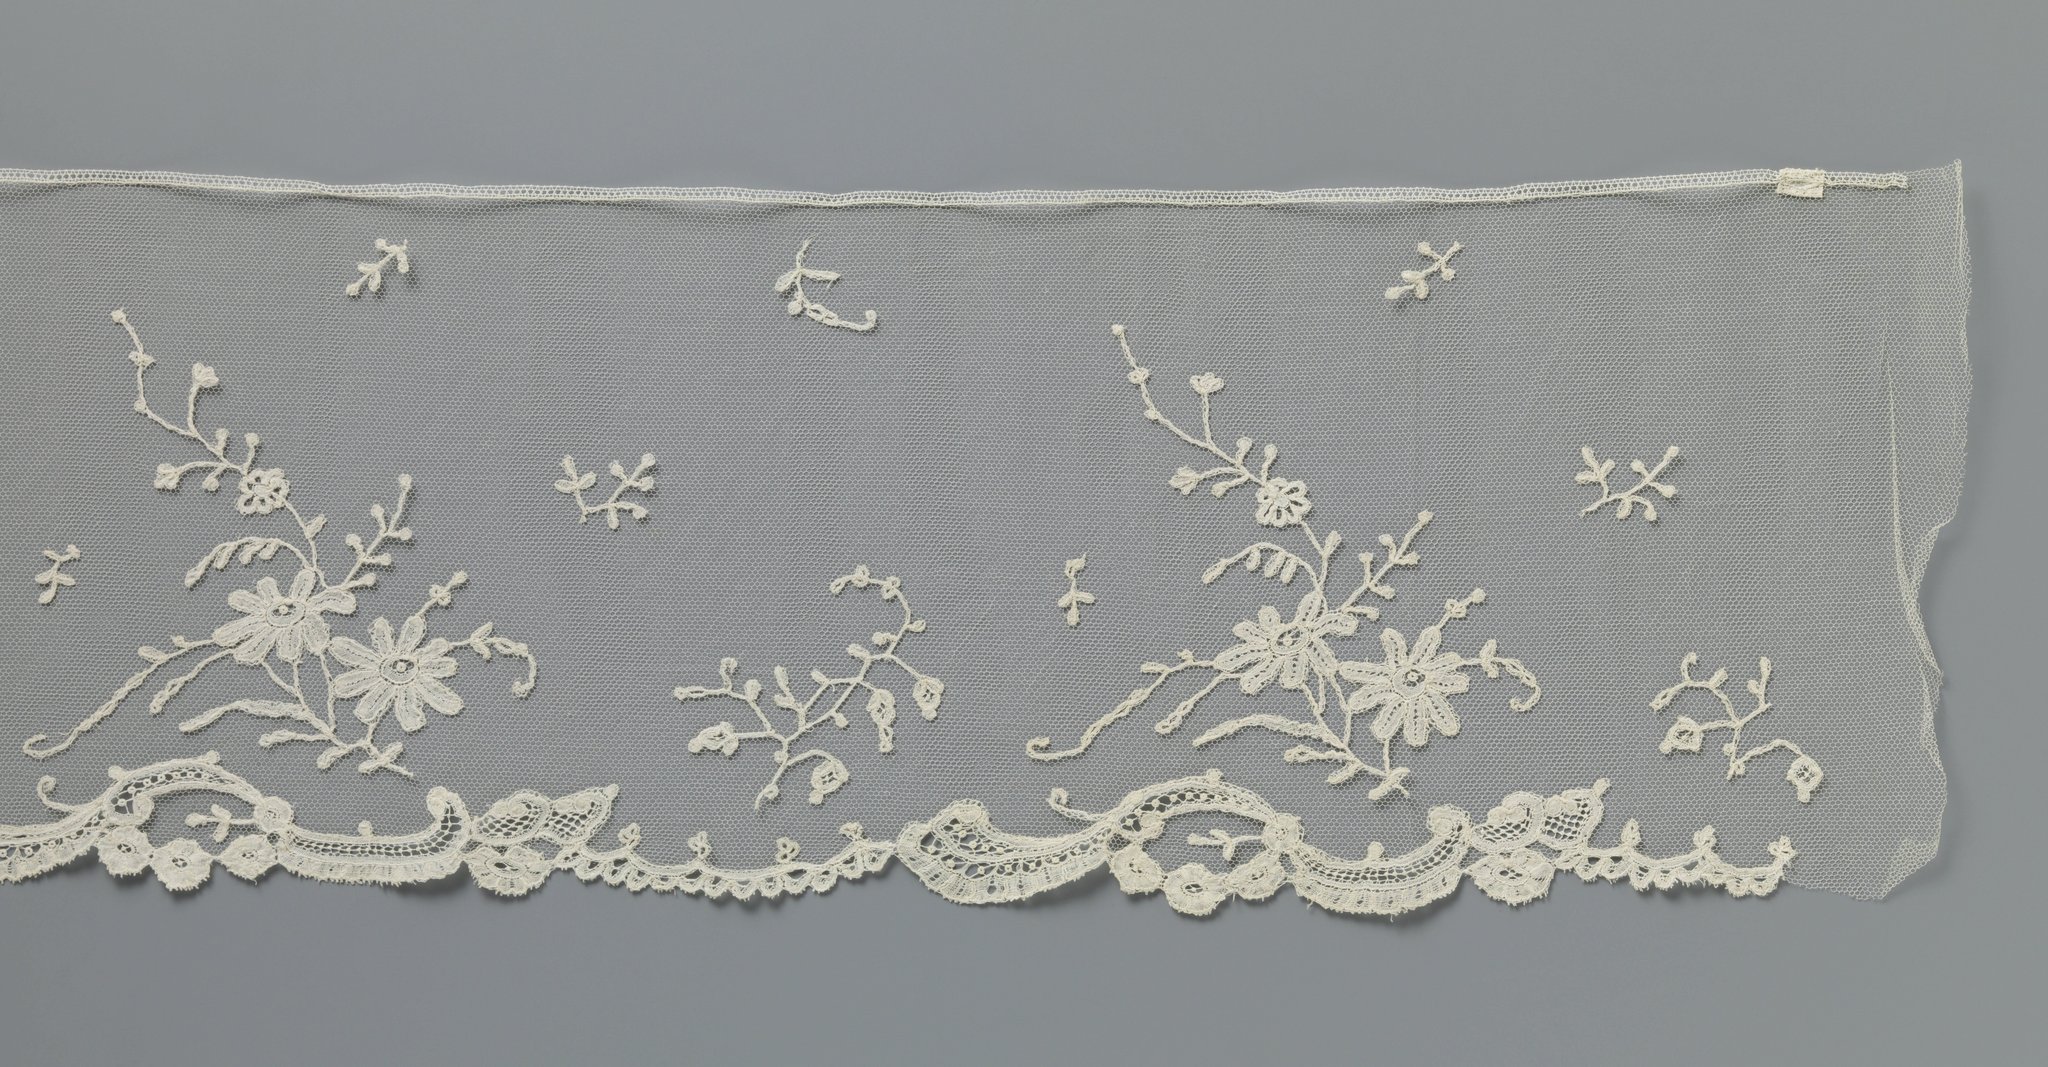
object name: strip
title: Strook applicatiekant met margrietentakken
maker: Anonymous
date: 1890-1899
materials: linen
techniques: lace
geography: brussels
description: Strook naturelkleurige applicatiekant, kloskant geappliceerd op machinale tule. Op een met takjes versierd fond staan, langs de geschulpte kant, afwisselend een grote tak met margrieten en een kleine tak met klokjesbloemen. De gestrekte schulpen vertonen onder andere gebroken c-voluten en met rasterwerk gevulde rocailles.